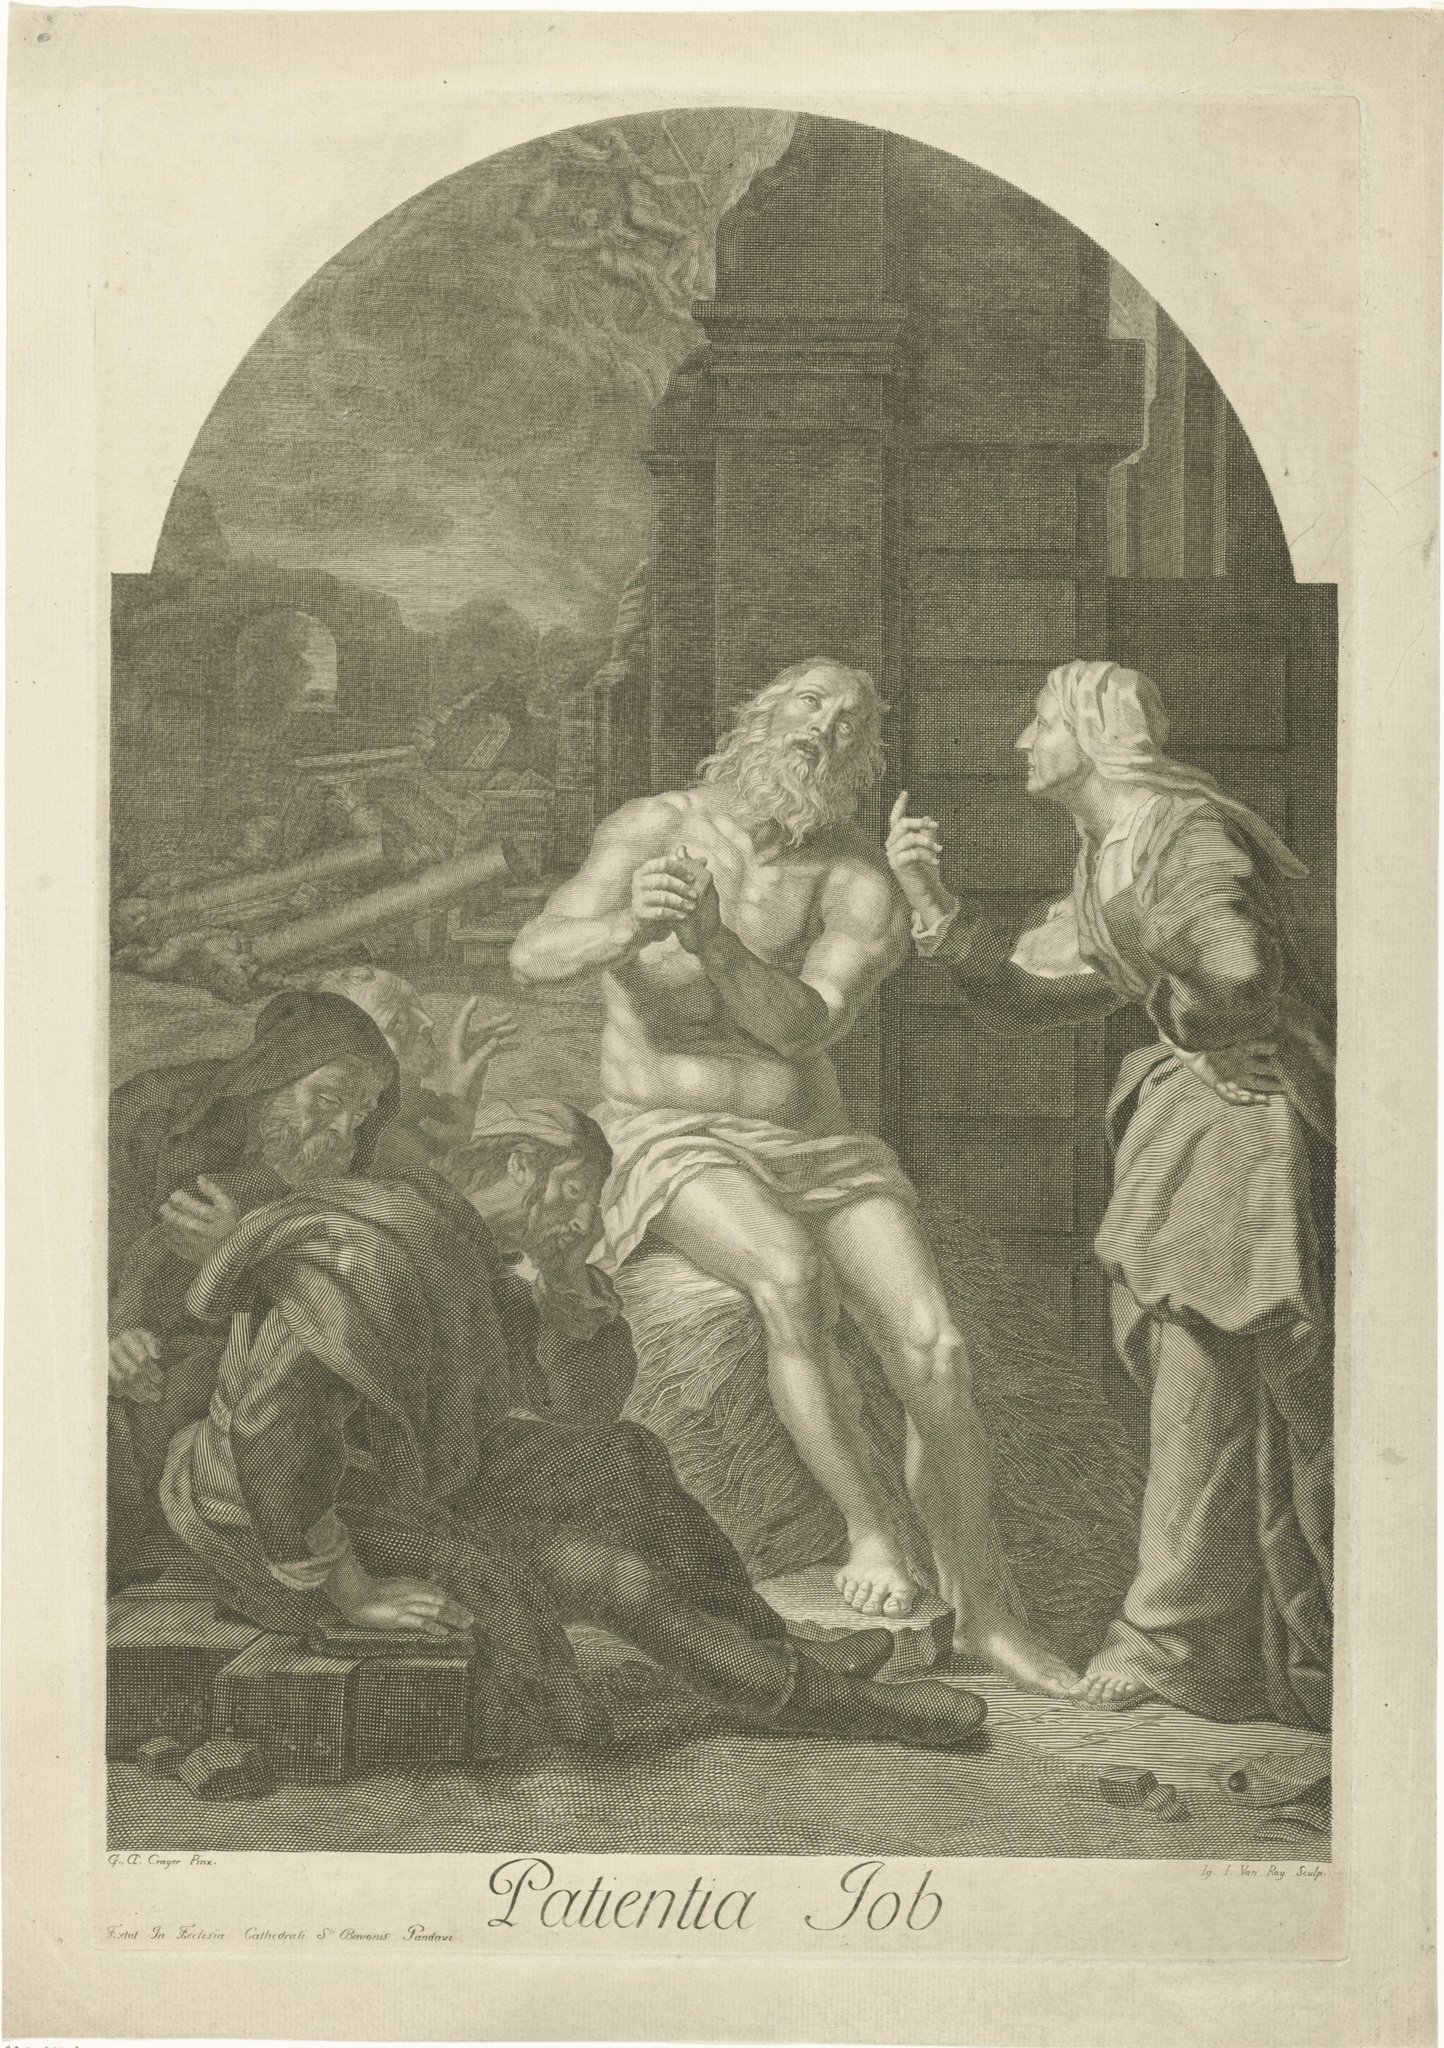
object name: print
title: Job op de mesthoop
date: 1594-1729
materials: paper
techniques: engraving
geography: southern netherlands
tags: job on the dunghill (job 2:7-13)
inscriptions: collector's mark: Lugt 2228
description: Bij een ruïne zit Job op een mestvaalt. Hij wordt beschimpt door zijn vrouw, die naast hem staat. Links zitten drie van zijn vrienden.